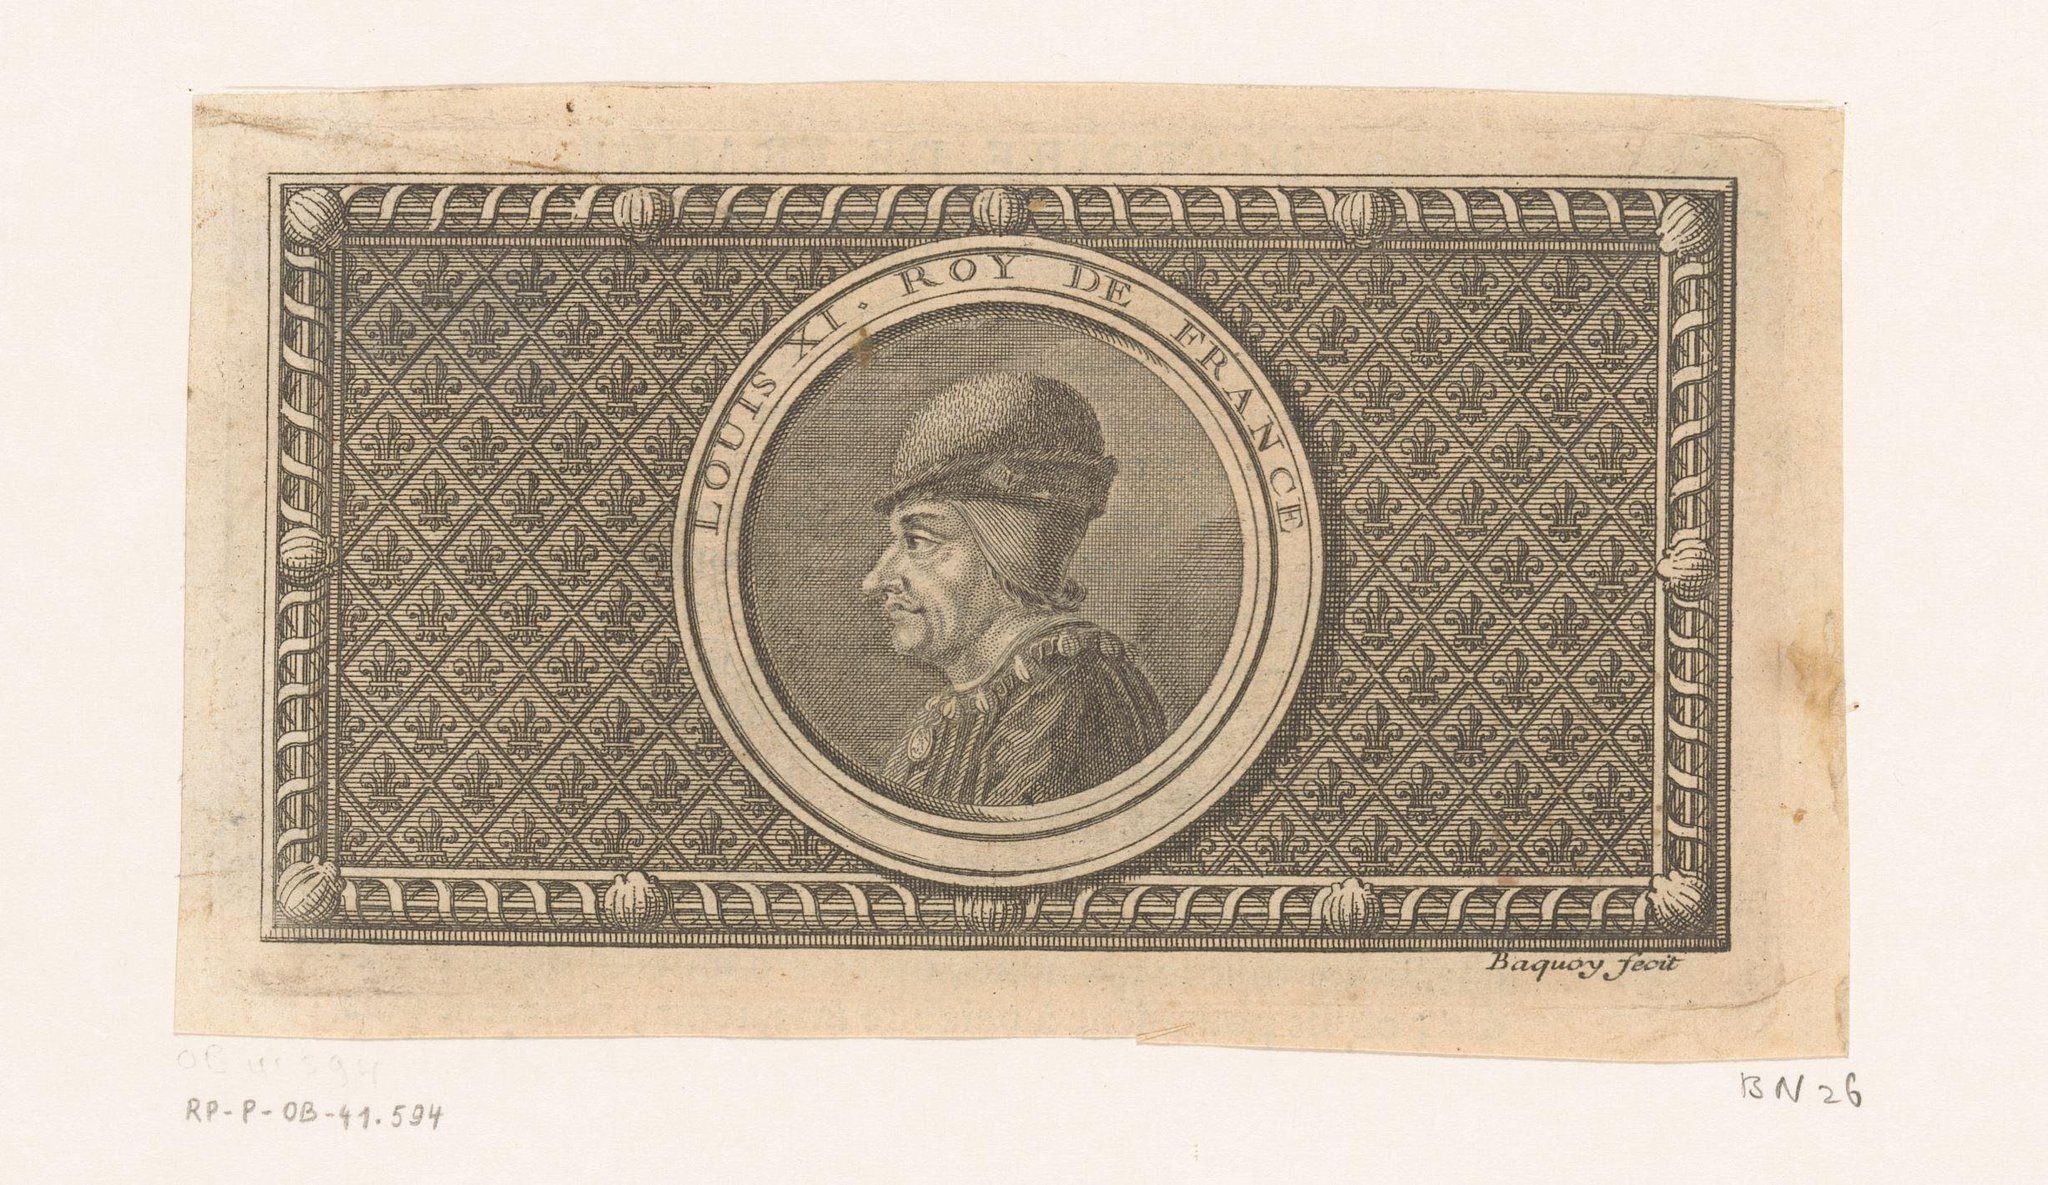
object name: book illustration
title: Portret van Lodewijk XI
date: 1727-1729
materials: paper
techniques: etching, letterpress printing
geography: france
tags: ornament ~ medallion, historical persons, ruler, sovereign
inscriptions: collector's mark: Lugt 2228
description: Prent uit: Daniel (Le P.). Histoire de France (...) Nouvelle édition (...). Parijs: Denis Mariette, 1727-1729, dl. 6, p. 331.